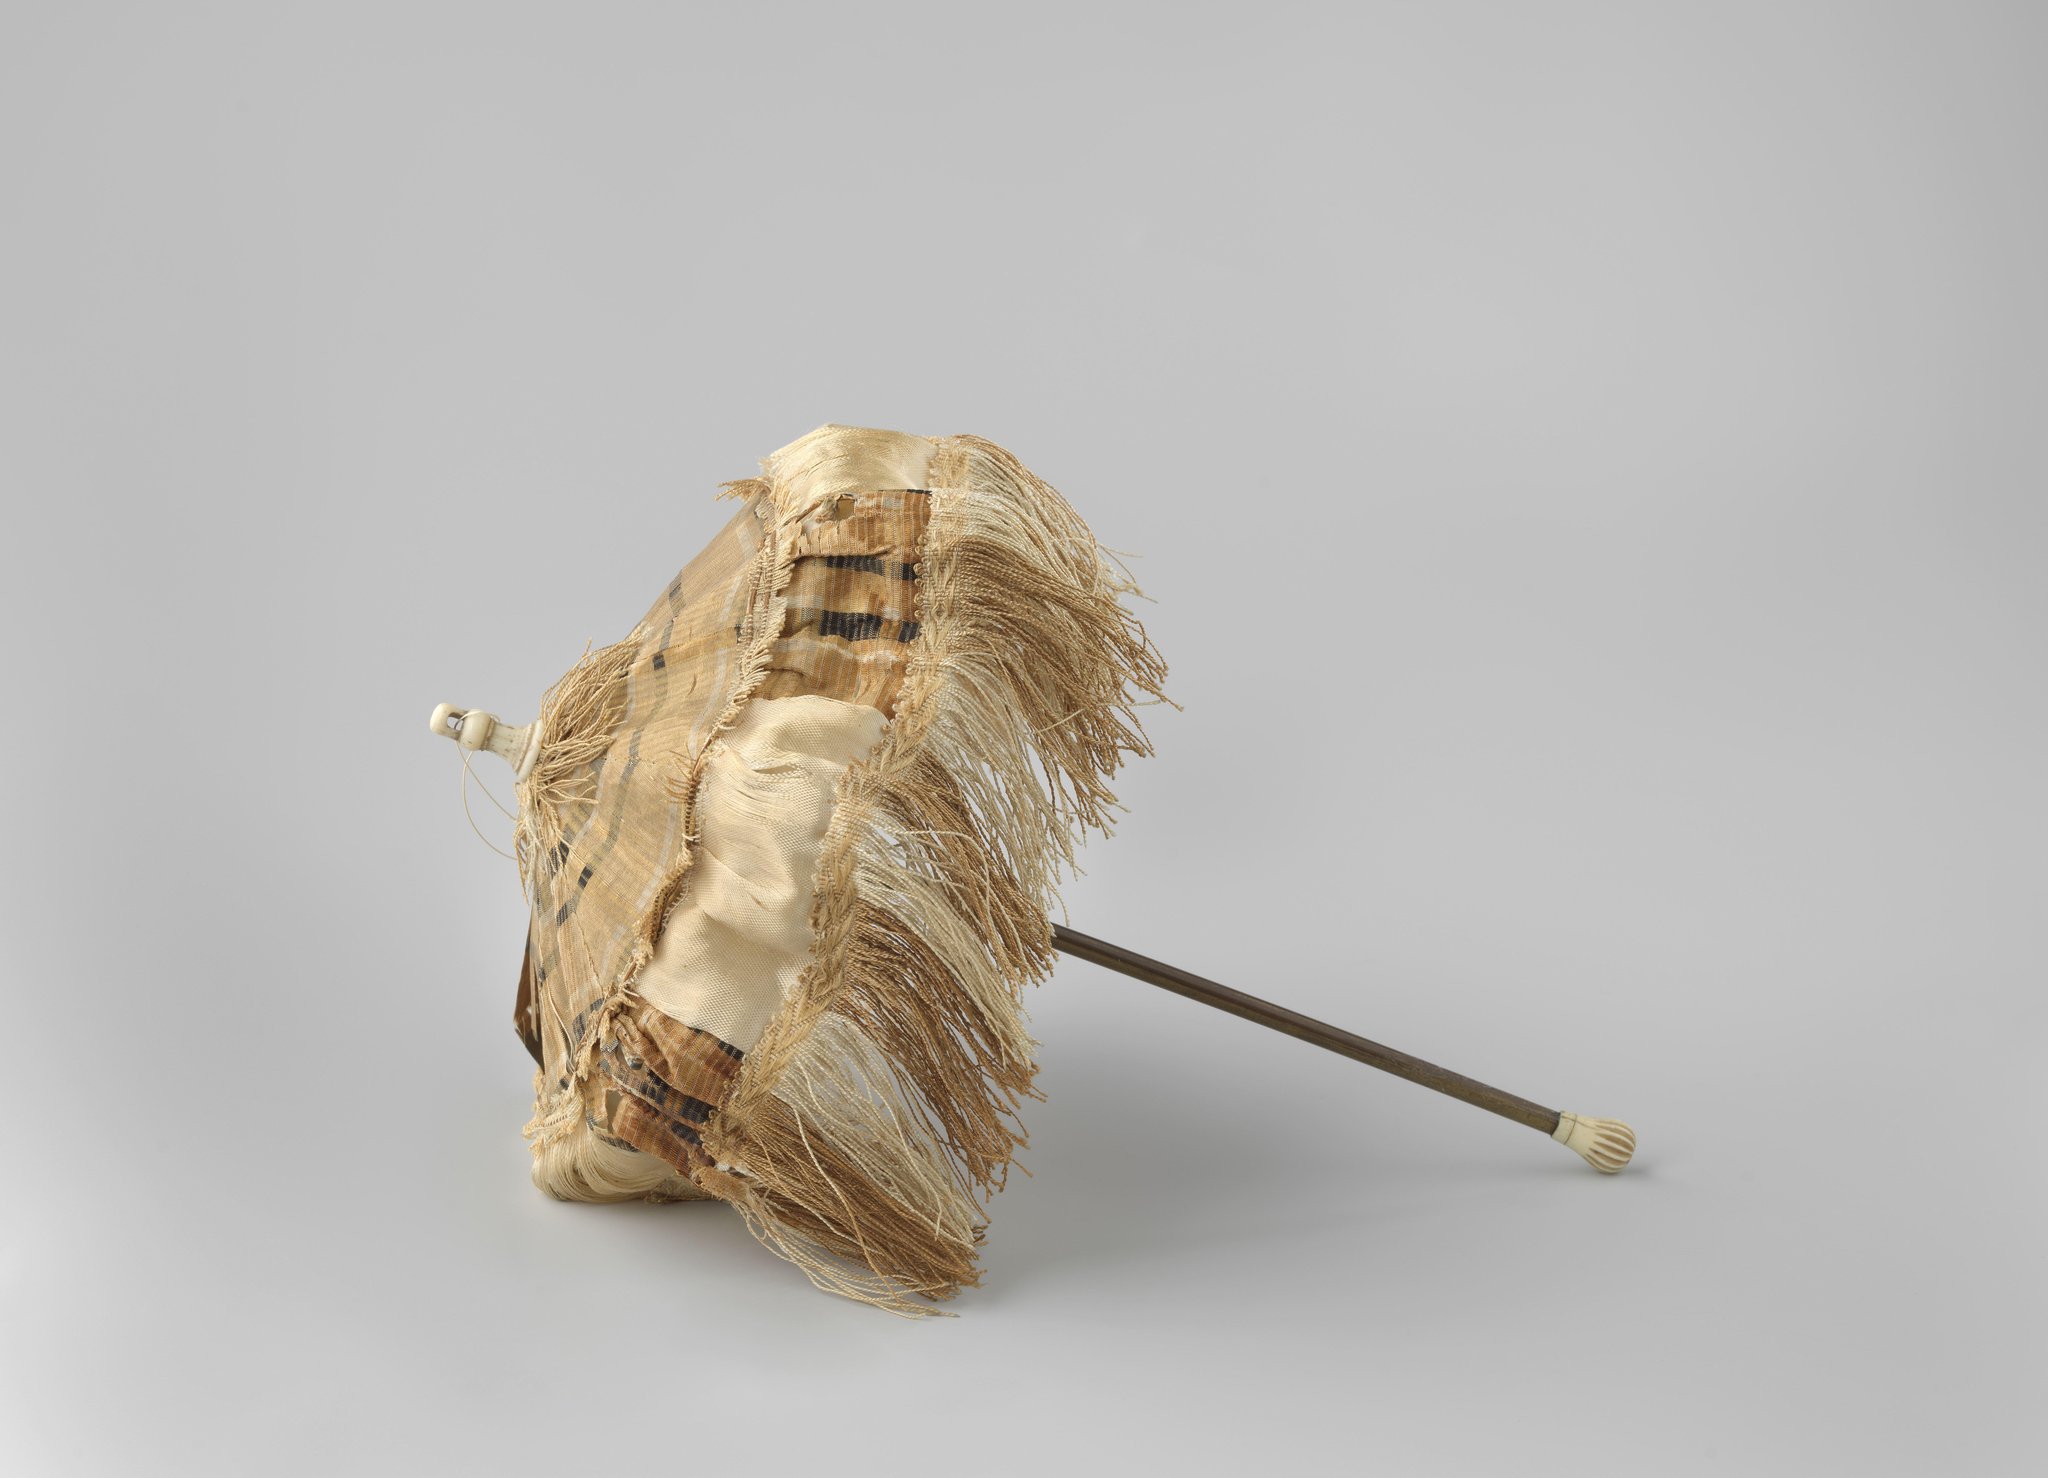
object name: clothing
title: Parasol van gestreepte zijde met franje.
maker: Anonymous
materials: copper, ivory, silk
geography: netherlands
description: Parasol van beige gestreepte zijde met dito franje; voering van witte zijde. Koperen stok met ivoren punt en knop.